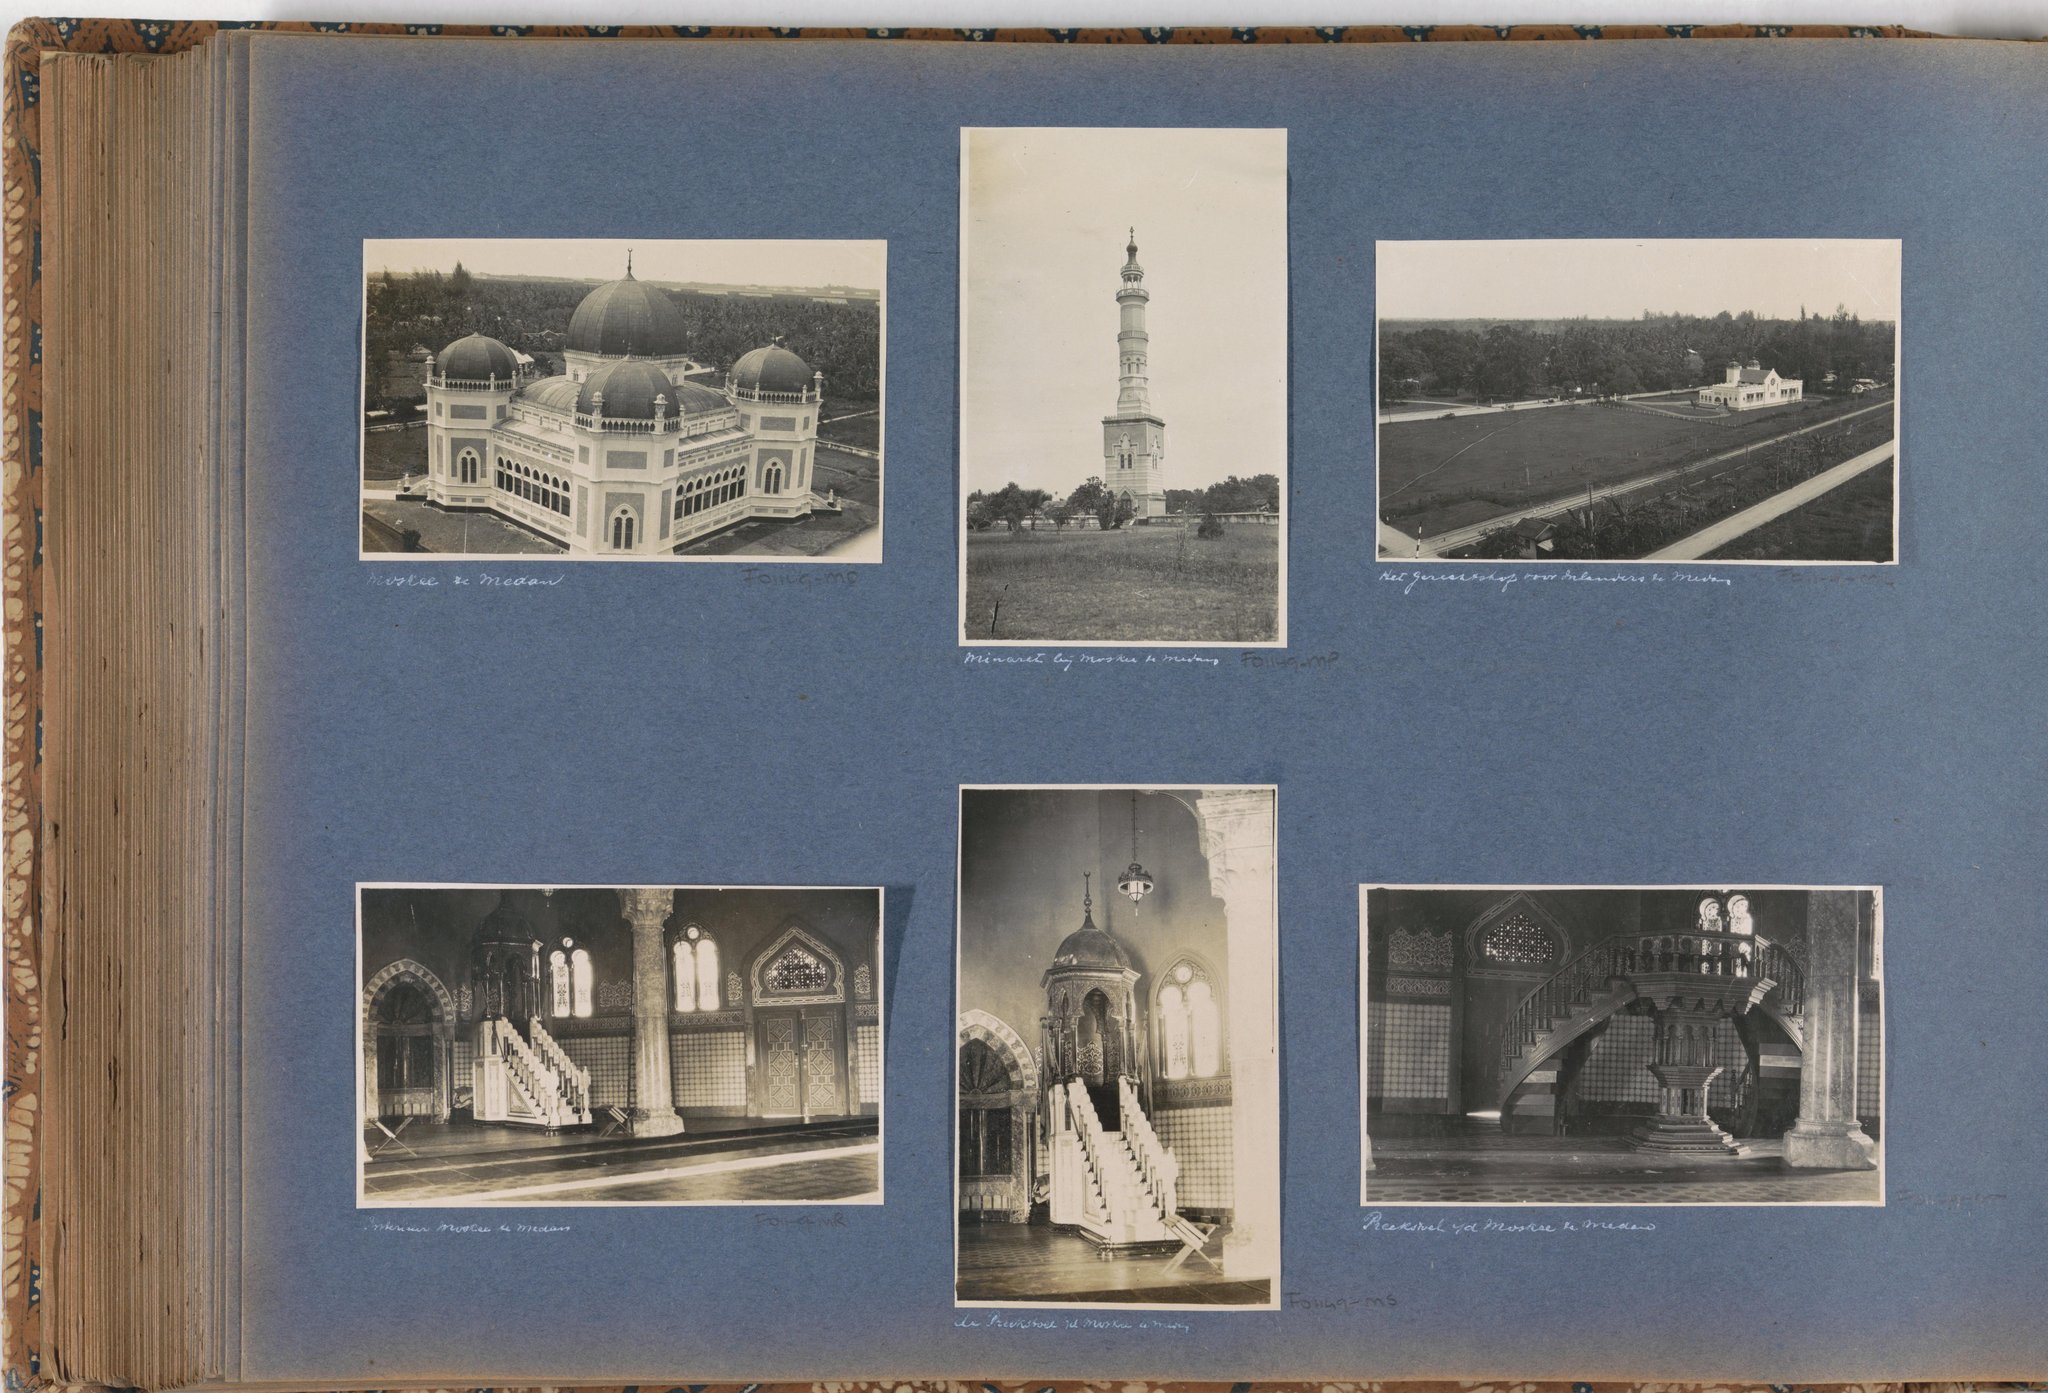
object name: album leaf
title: Preekstoel van de Grote Moskee (Masjid Raya Al Mashun) in Medan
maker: Anonymous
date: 1900-1920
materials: paper, photographic support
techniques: gelatin silver print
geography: medan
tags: pulpit, ambo, chancel, temple, shrine ~ islam, mohammedanism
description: Onderdeel van reisalbum met foto's van bedrijvigheid en bezienswaardigheden op Sumatra en Java en van de reis naar en van Nederlands-Indië.